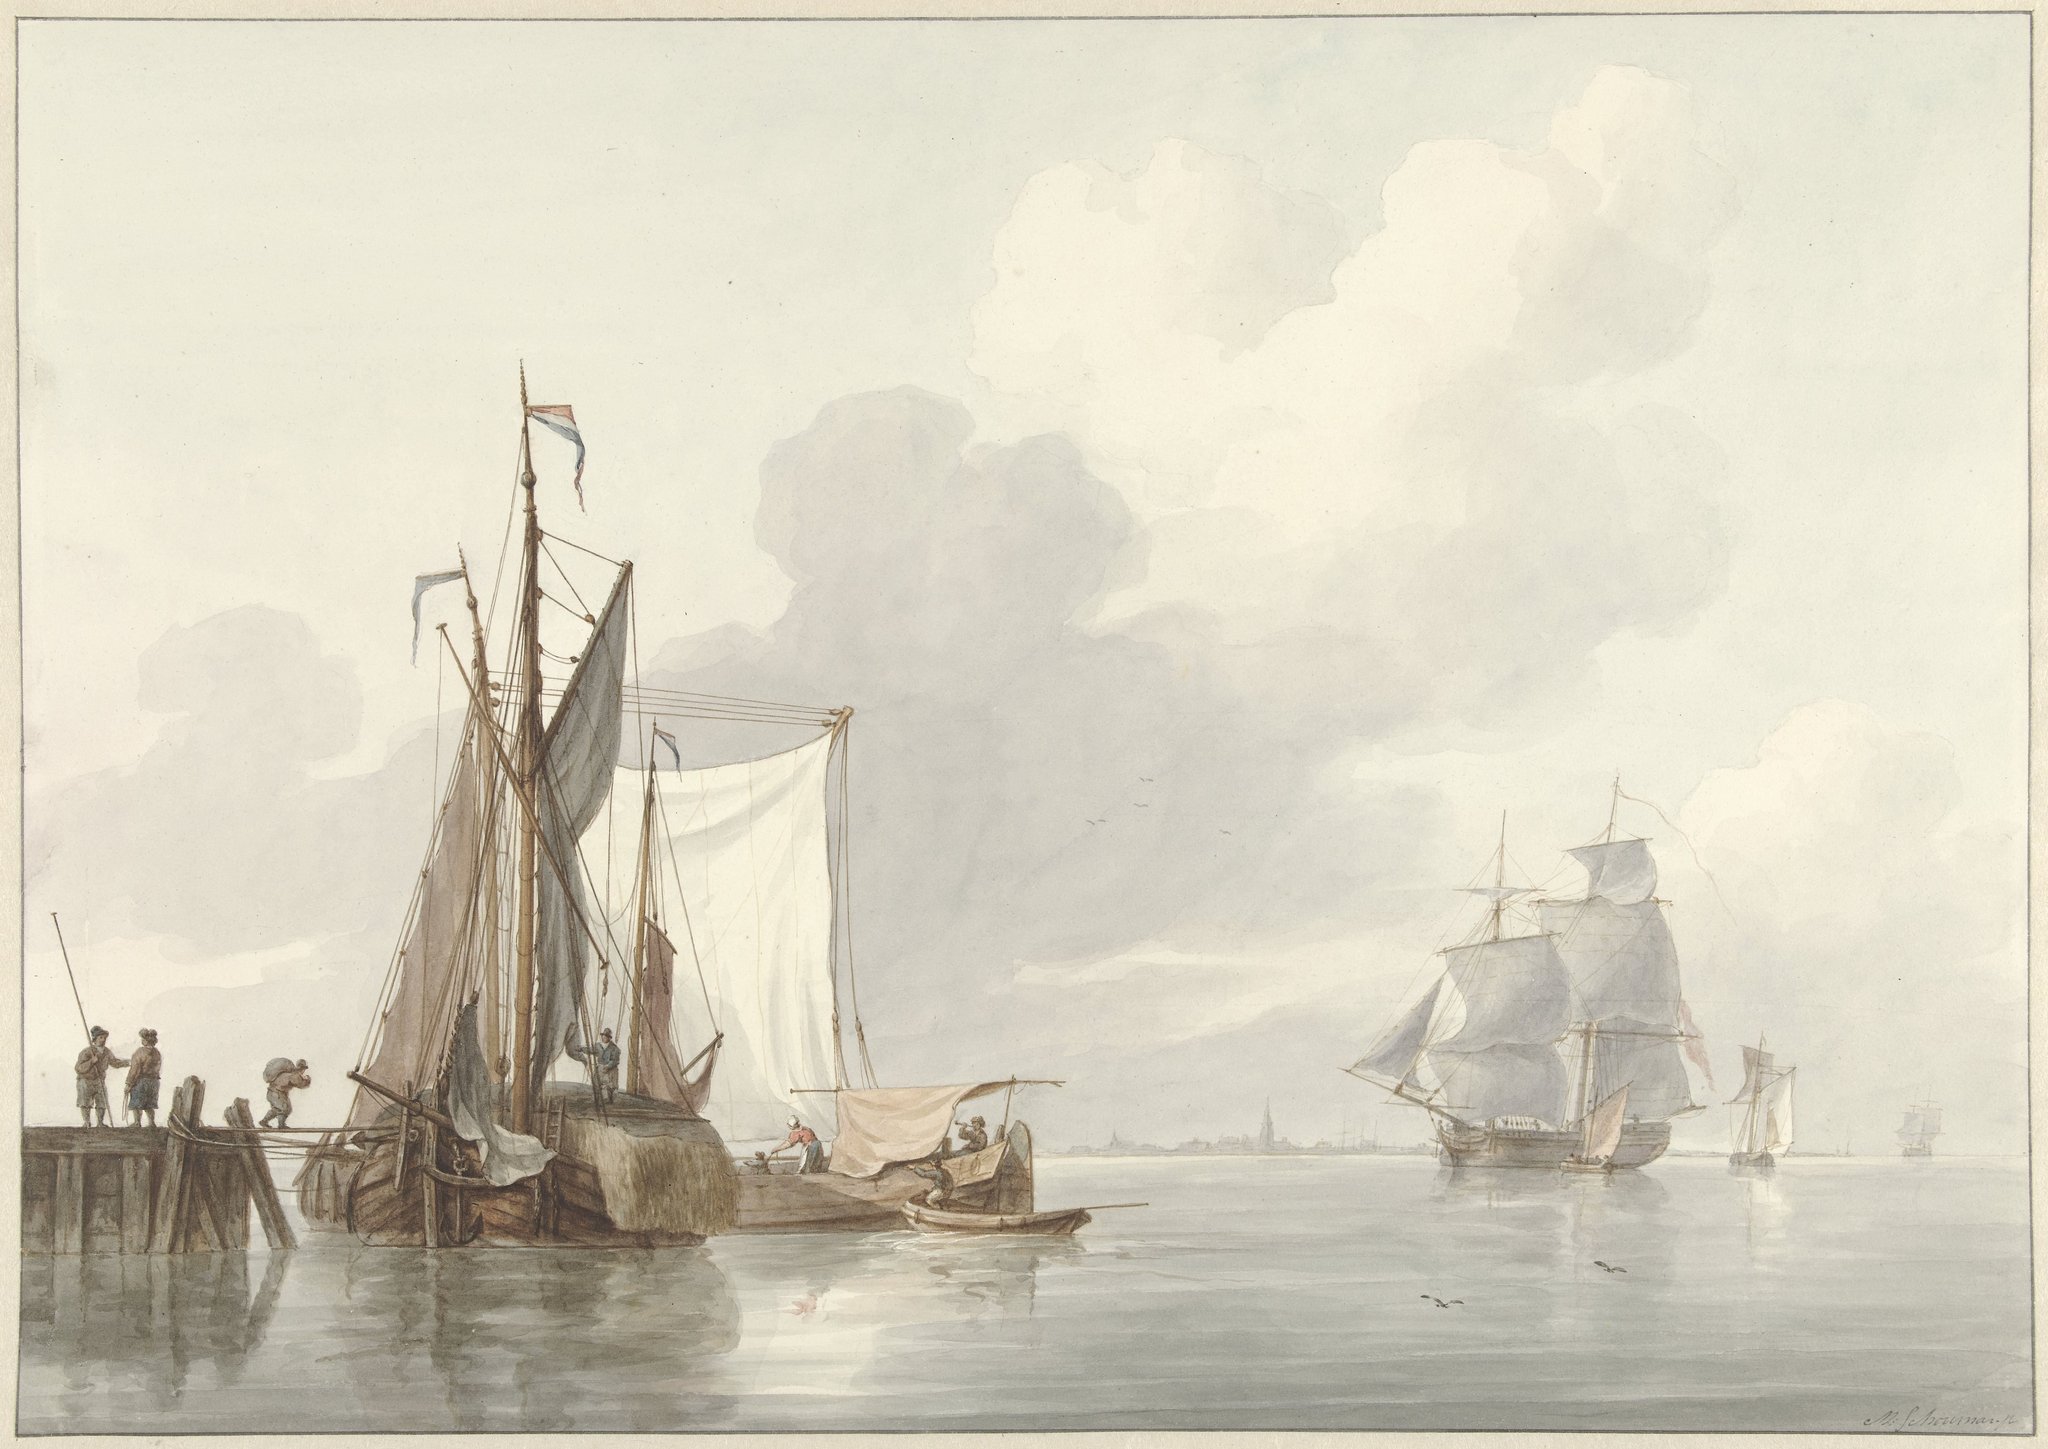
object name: drawing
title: Riviergezicht met afgemeerde schepen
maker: martinus schouman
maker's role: draughtsman, painter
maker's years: 1770-1848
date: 1780-1848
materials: paper, watercolor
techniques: brush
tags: sailing-ship, sailing-boat, river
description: Riviergezicht met afgemeerde schepen; in het verschiet een groot zeilschip en een stad.